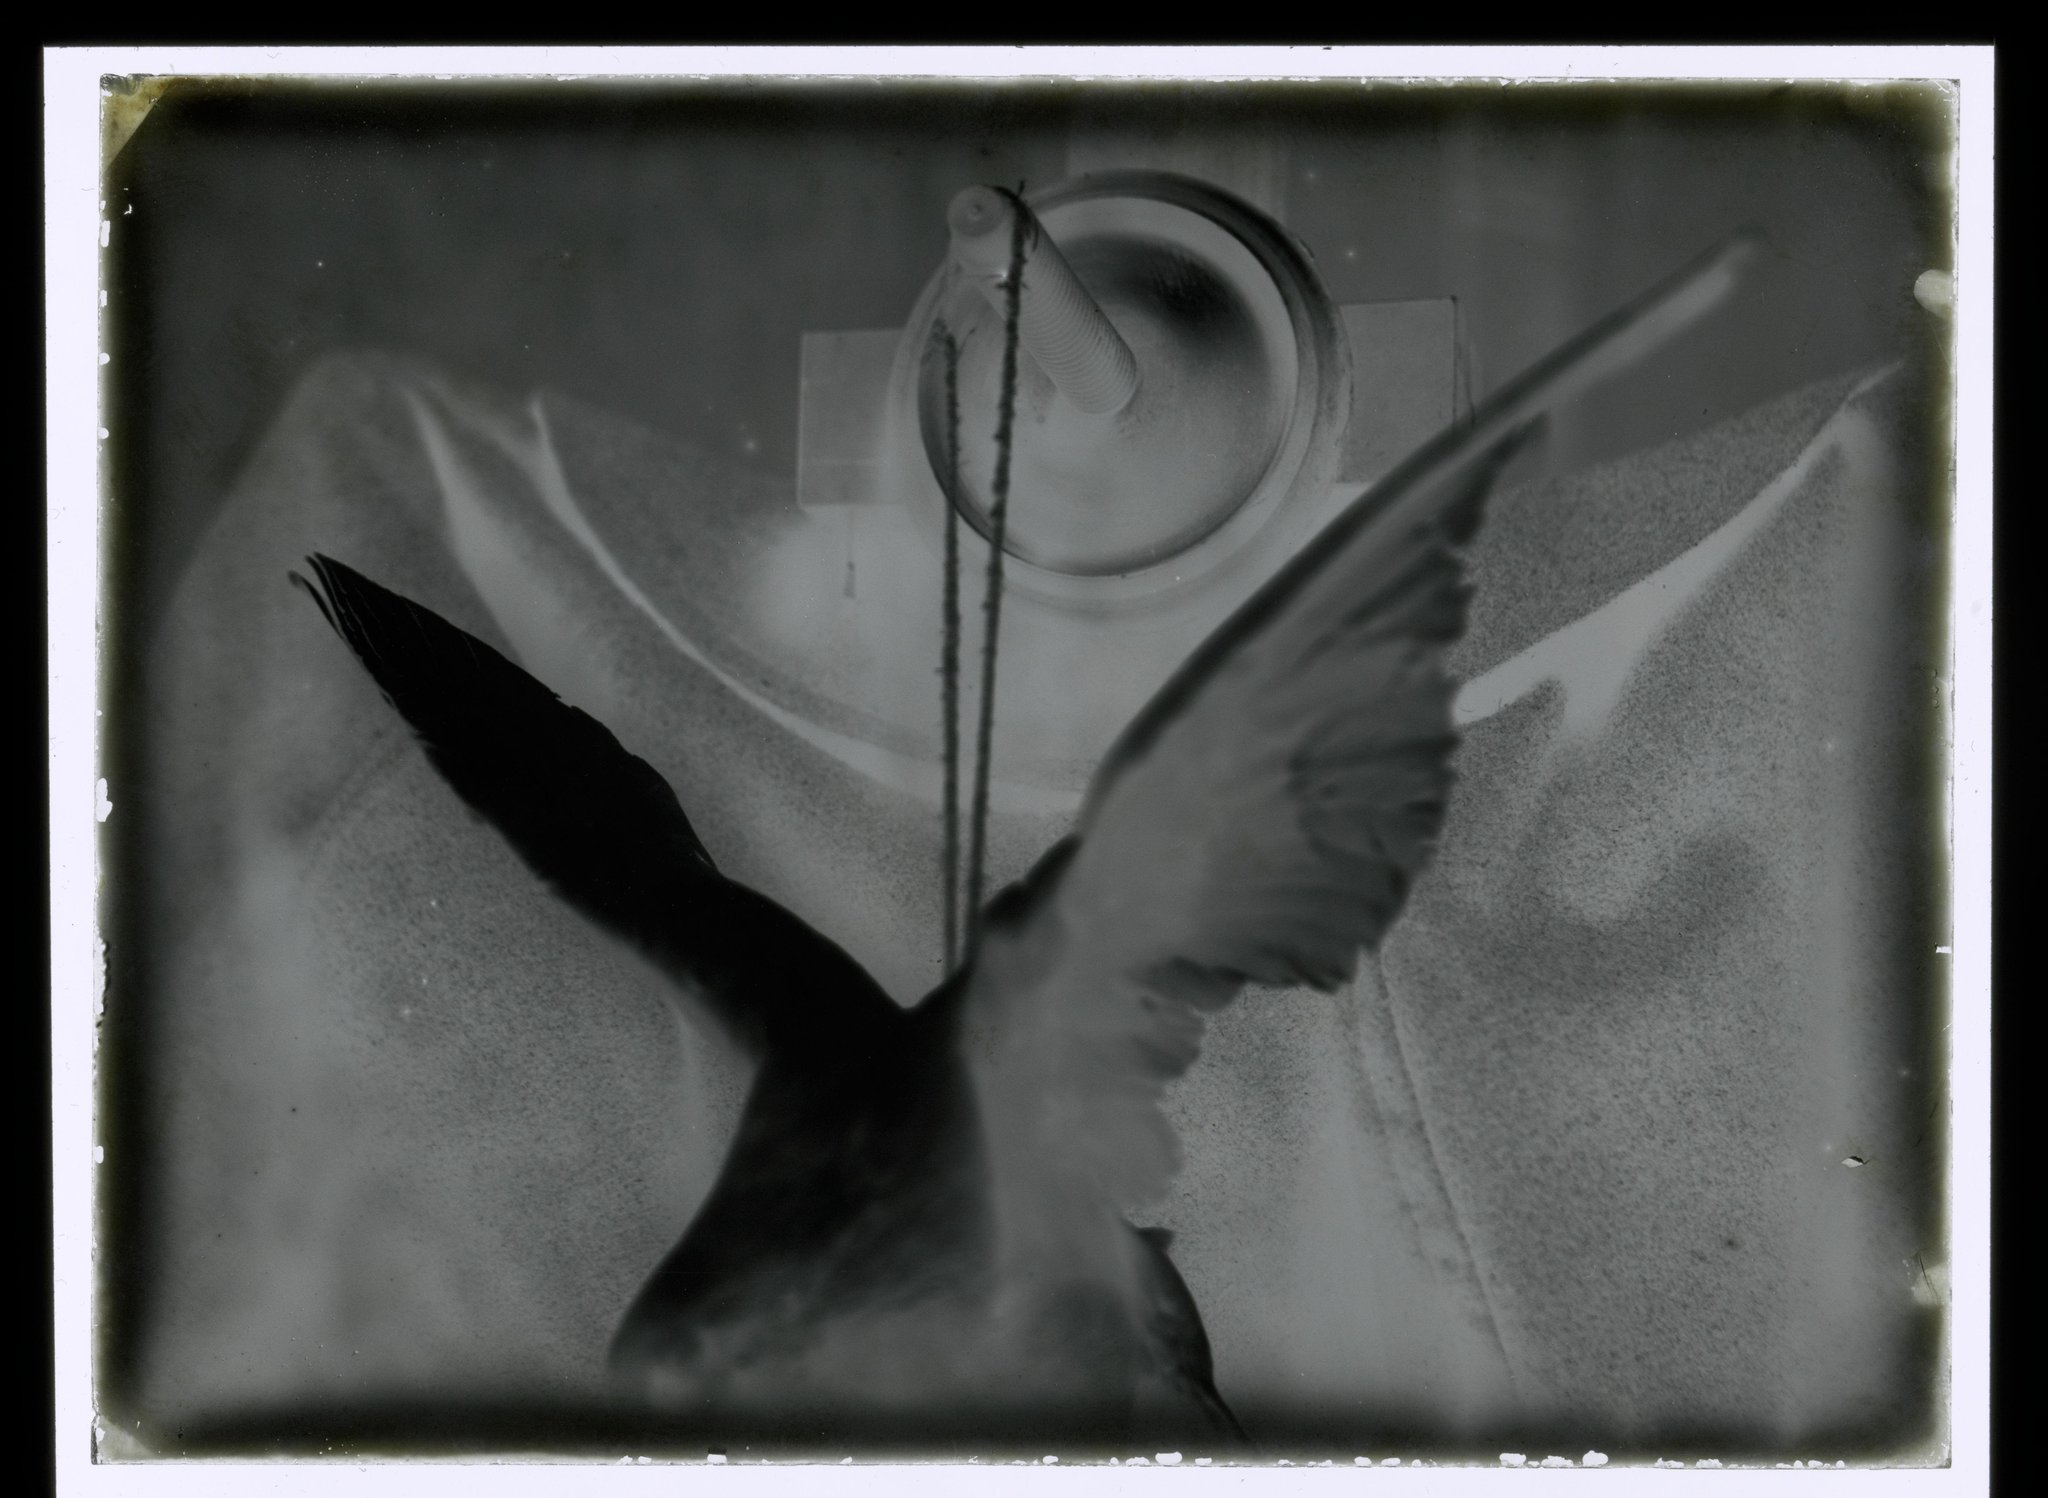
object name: glasnegatief, glasplaatnegatief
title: Stilleven met een duif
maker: laurens lodewijk kleijn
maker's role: draughtsman, painter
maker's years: 1826-1909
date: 1865-1900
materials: glass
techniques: collodion process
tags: doves, pigeons, still life of miscellaneous objects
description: Onderdeel van groep glasnegatieven uit de nalatenschap van de schilder Laurens Lodewijk Kleijn, stillevens, portretten, zelfportretten en kunstreproducties.